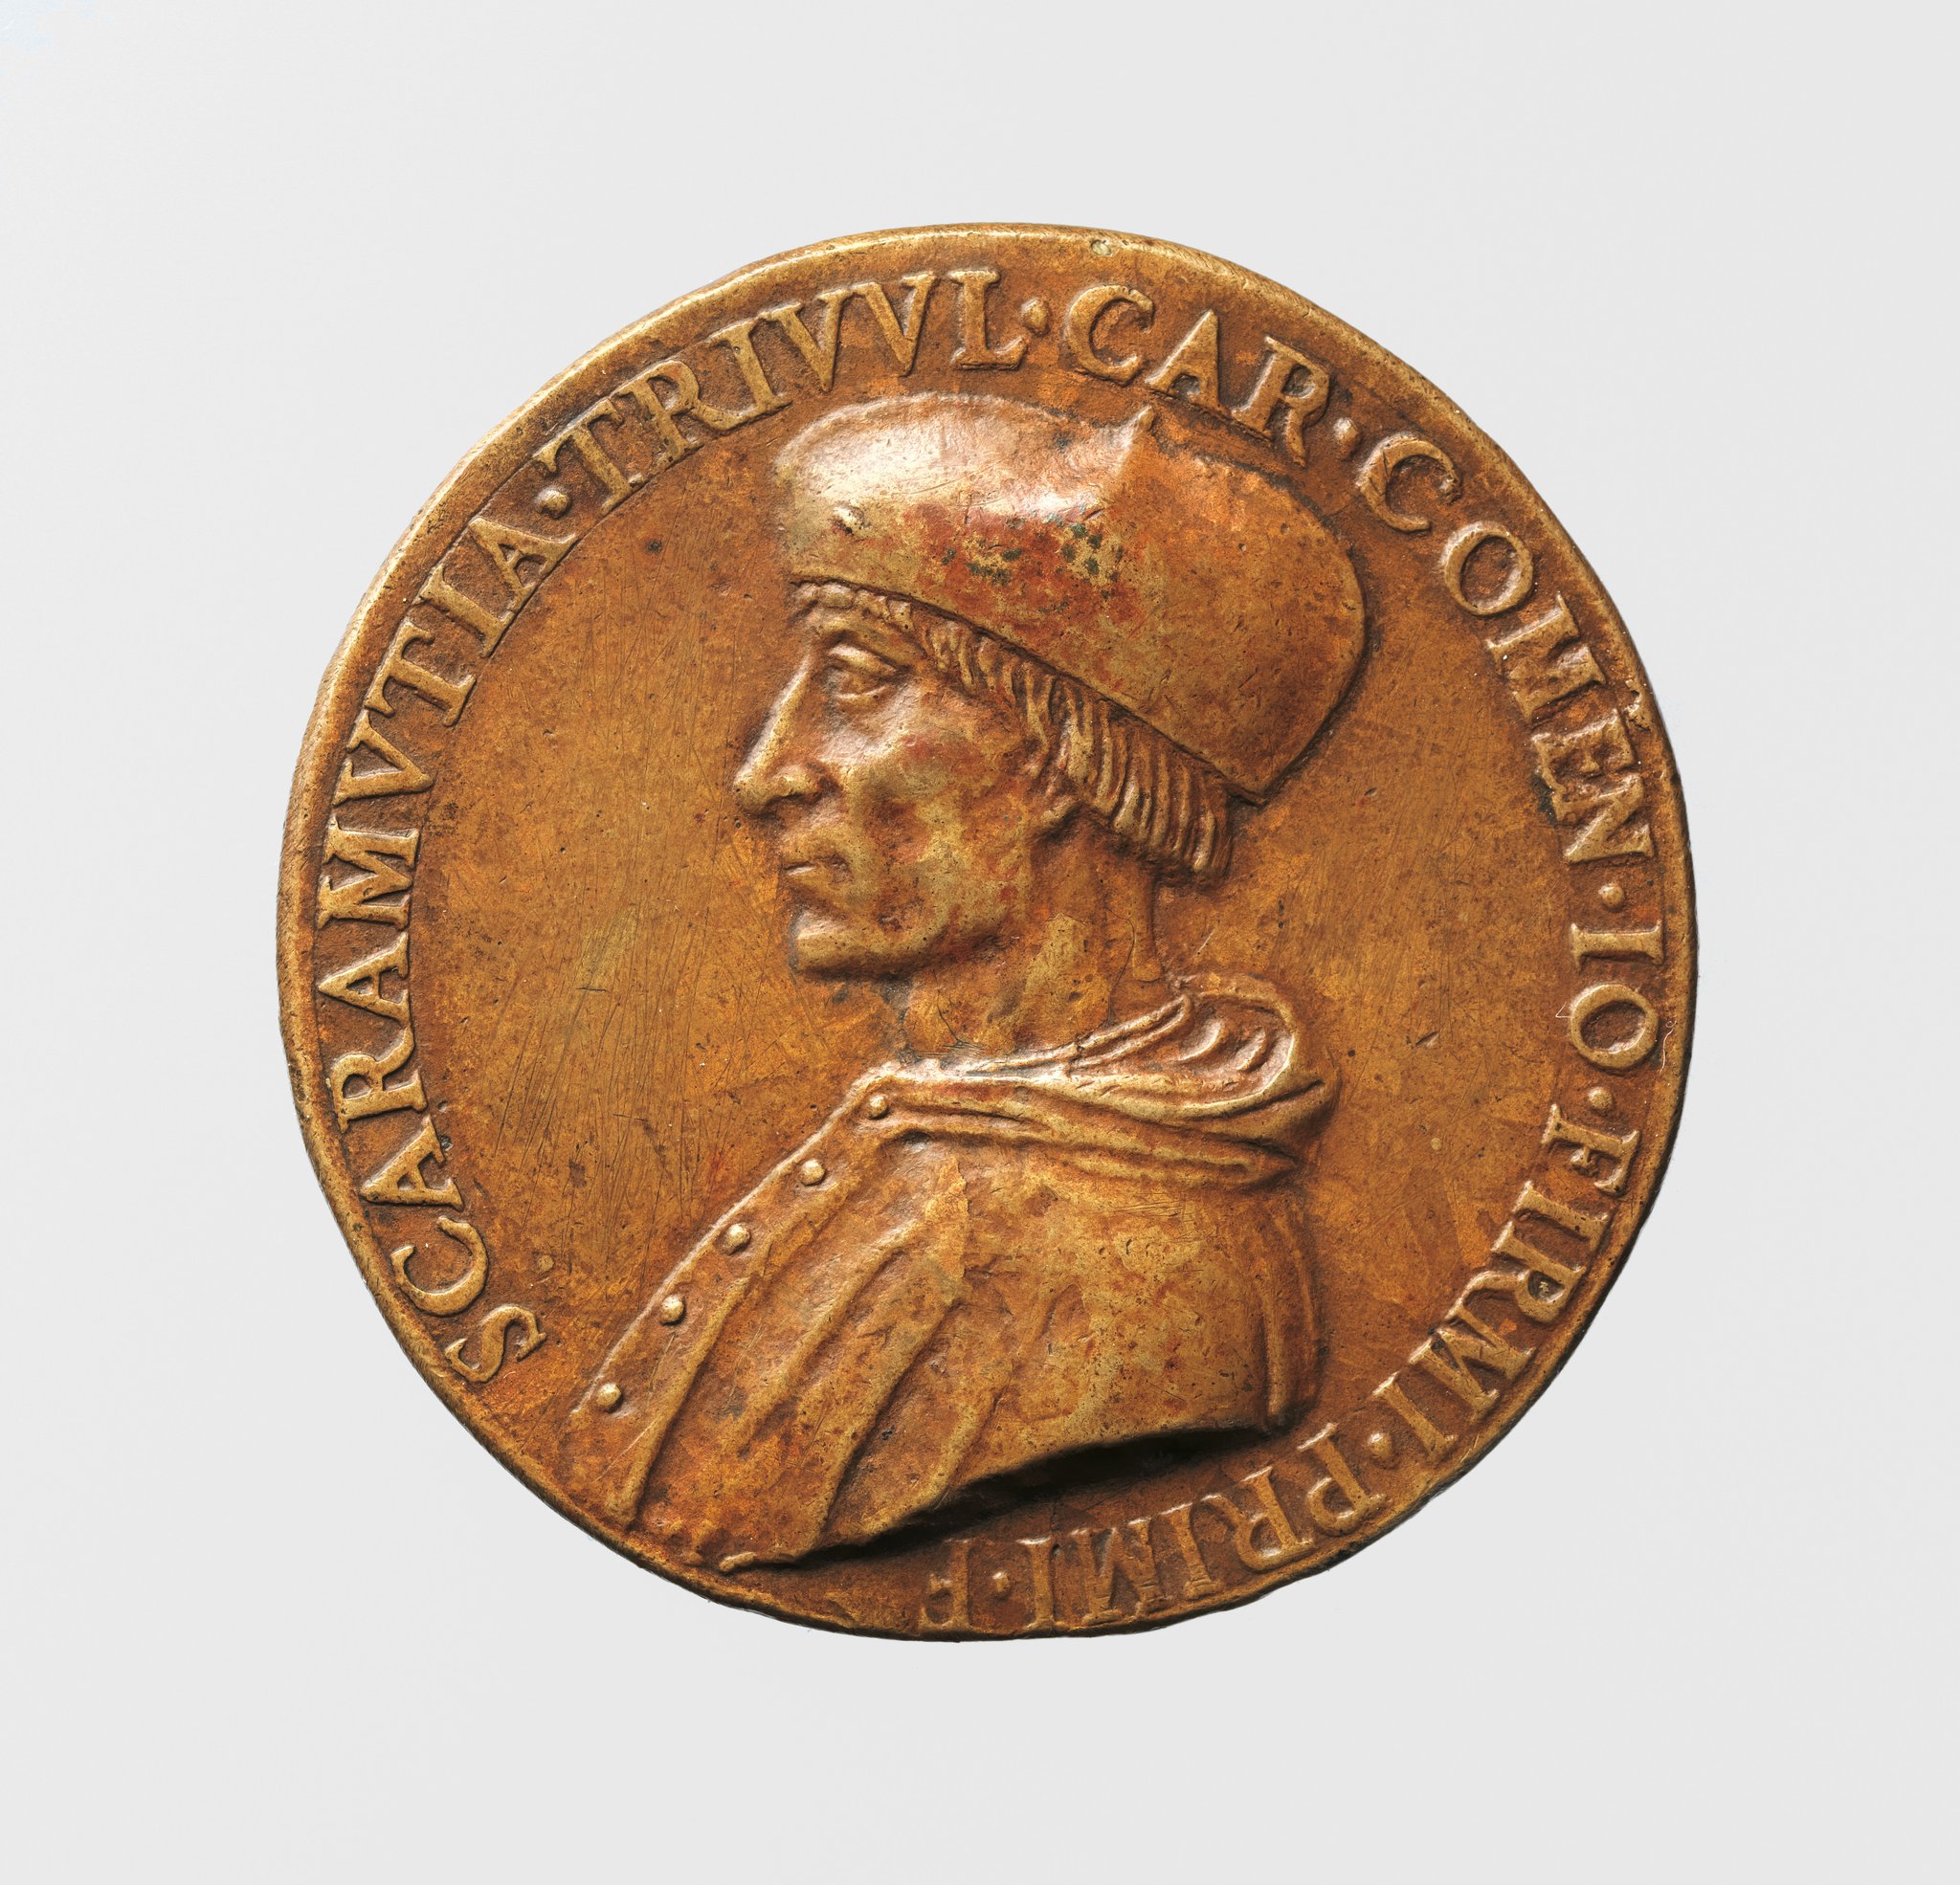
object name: medal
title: Portrait medal of Scaramuccia Trivulzio (obverse); Prudence (reverse)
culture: italian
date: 1517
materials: bronze, copper alloy, patina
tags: men,portraits,profiles